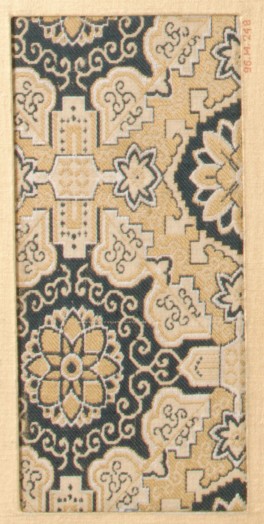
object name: piece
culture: japanese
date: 1701-1900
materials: silk